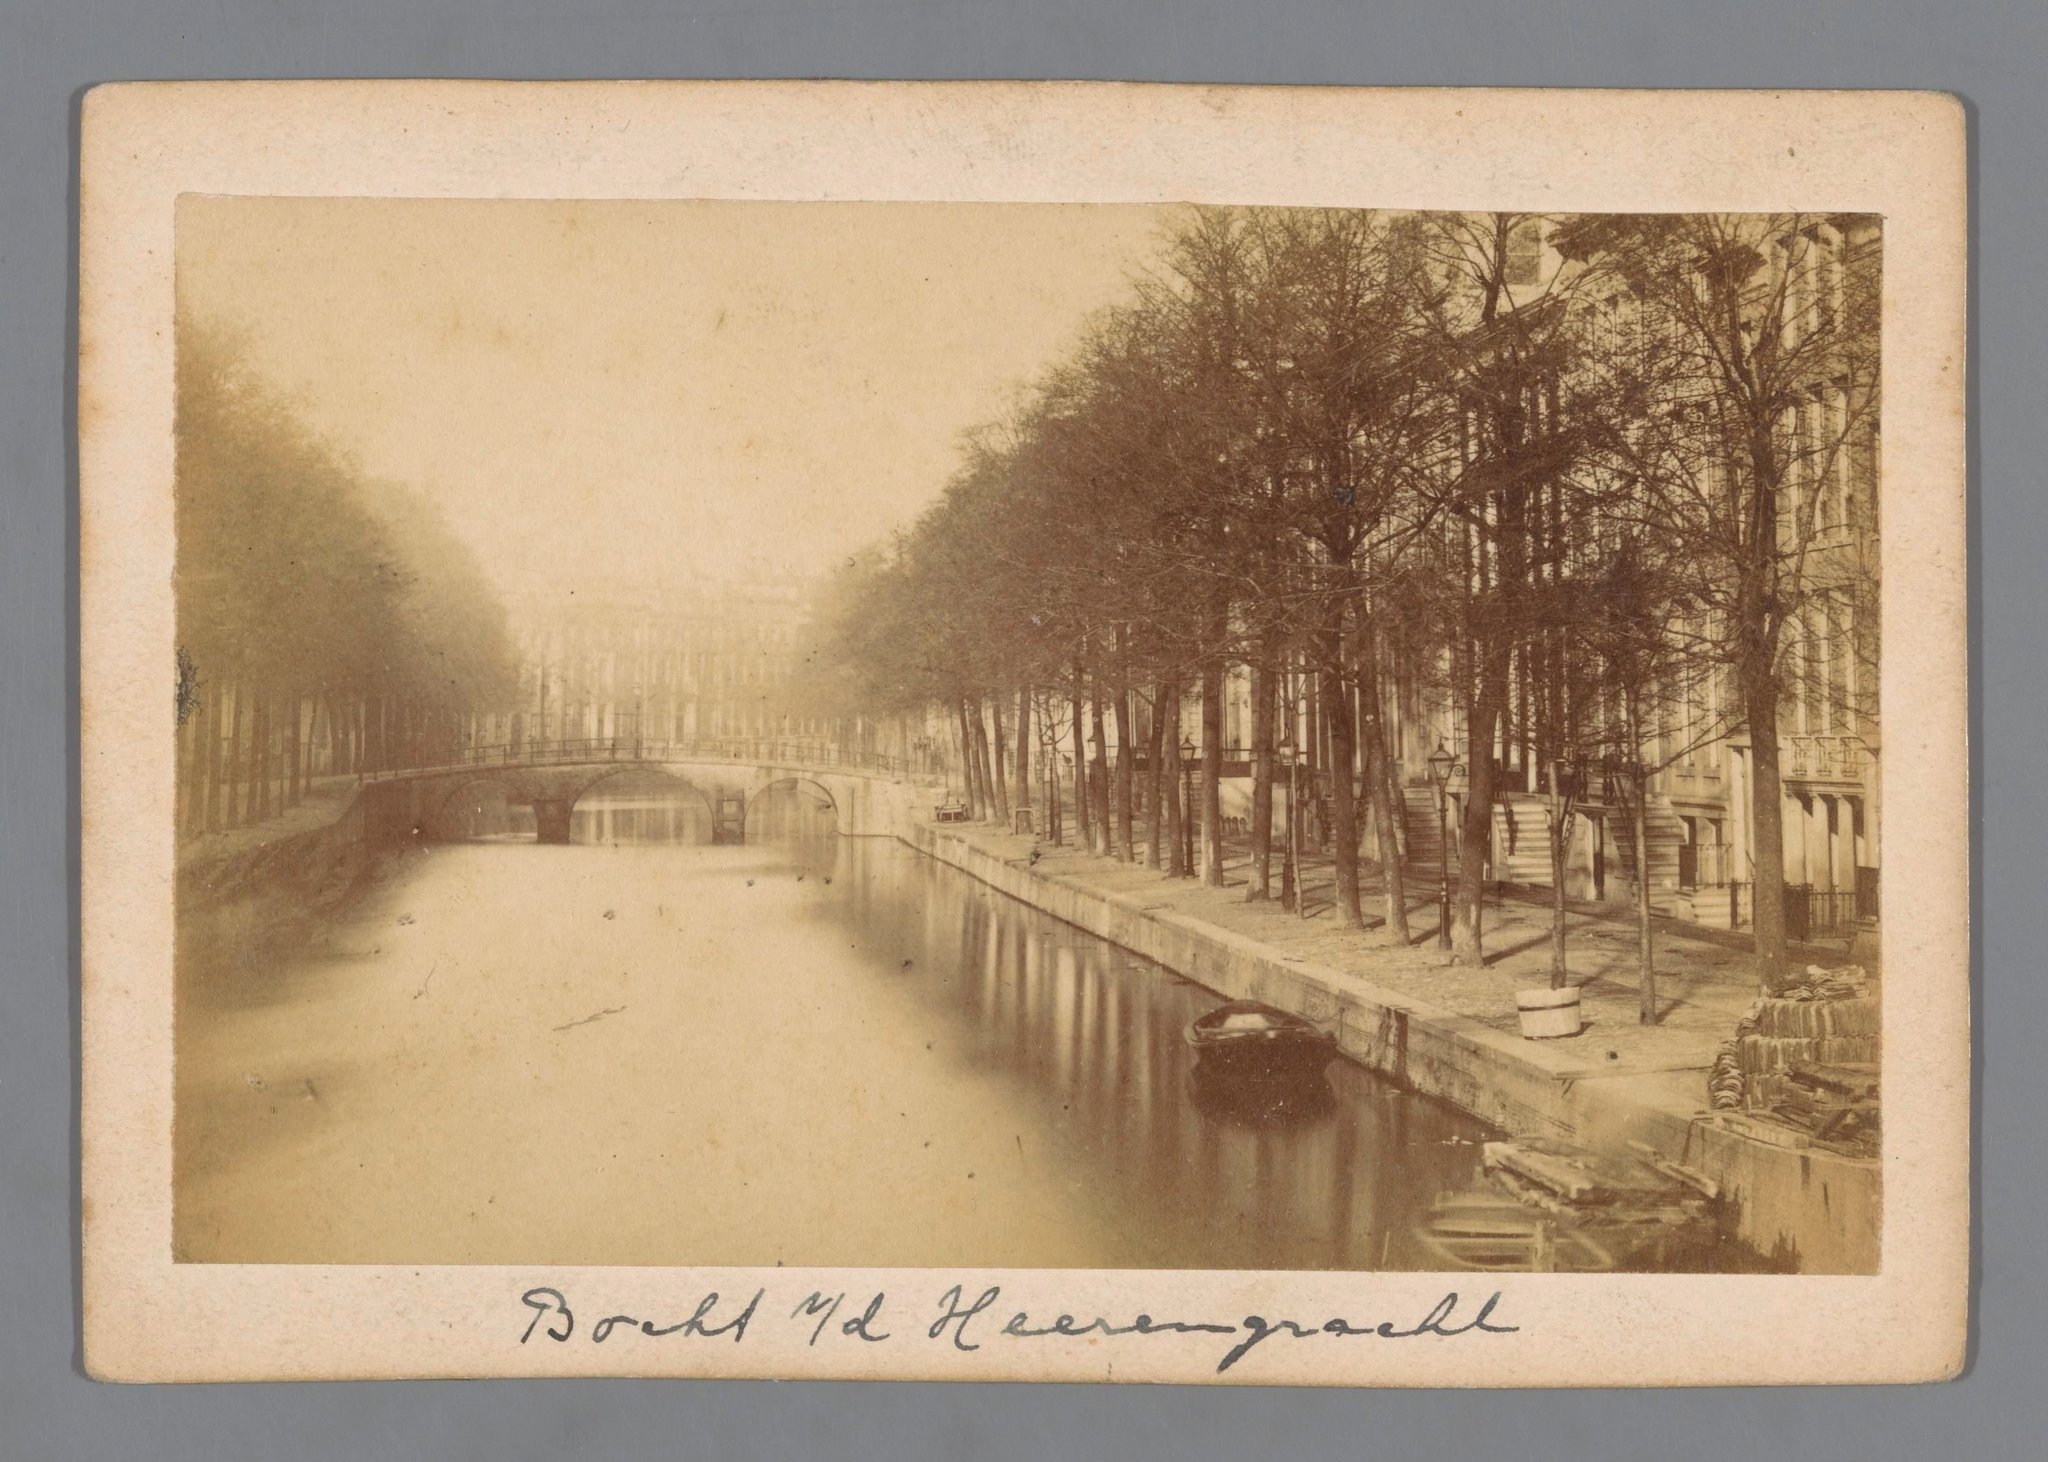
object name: photograph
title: Gezicht op de Herengracht in Amsterdam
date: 1850-1880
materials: cardboard, photographic support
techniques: albumen print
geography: amsterdam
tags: canals, waters (in city)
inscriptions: annotation: ‘Bocht v/d Heerengracht’, inscription: ‘7. Bocht van de Heerengracht./ Boekhandel. - C. F. Stemler. - Amsterdam.’, number: ‘3.50’